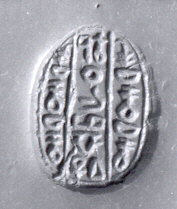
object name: stamp seal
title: Scarab seal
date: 1700-1520 BCE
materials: stone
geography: egypt or levant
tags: hieroglyphs